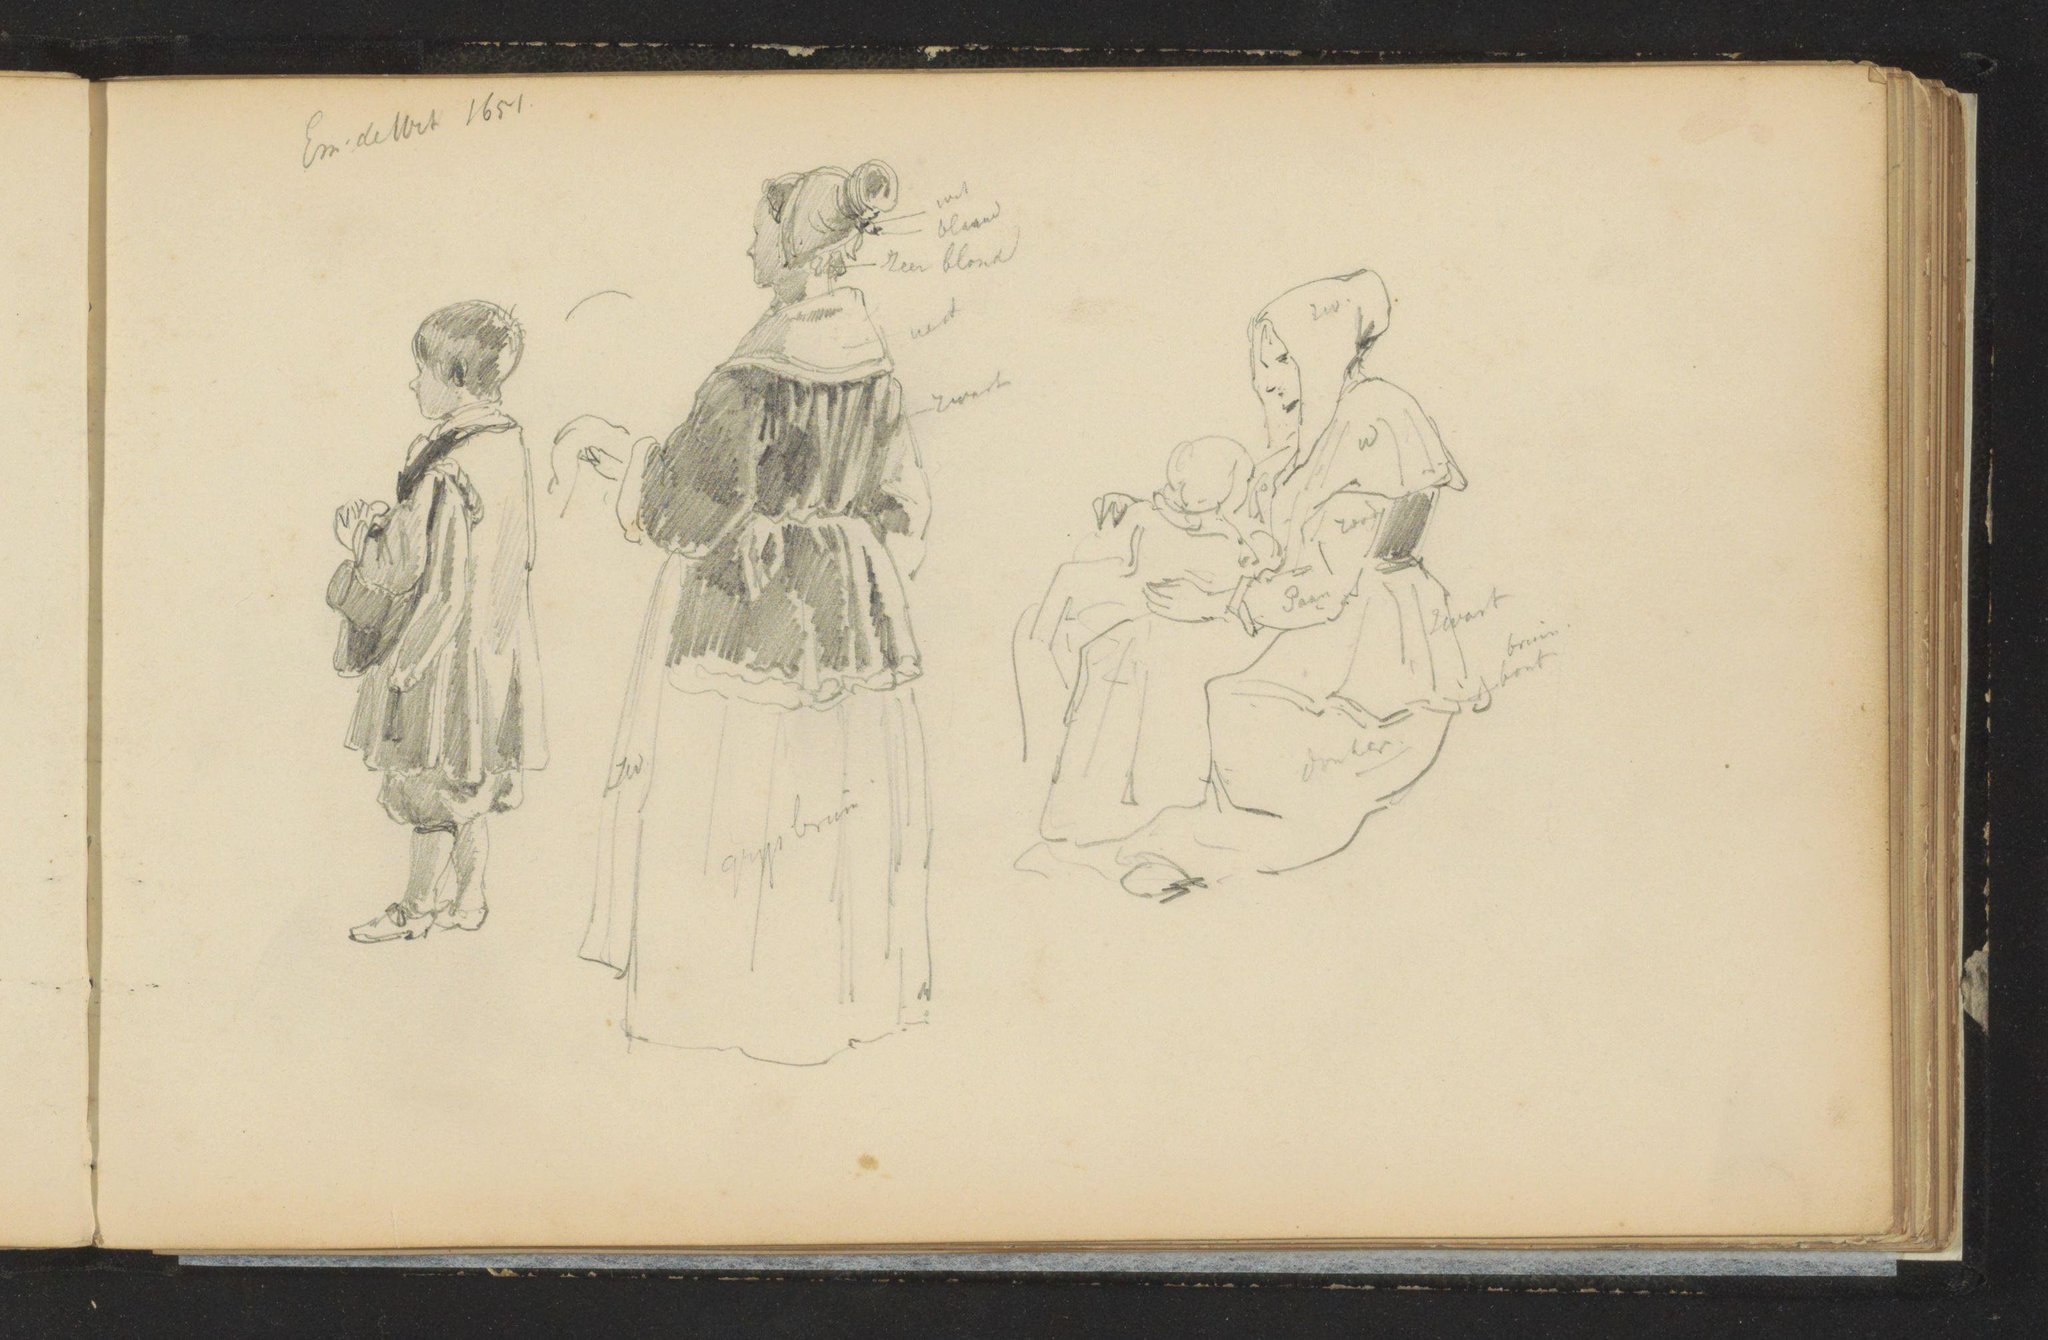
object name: sketchbook leaf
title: Vrouwen en kinderen in zeventiende-eeuwse kleding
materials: paper, pencil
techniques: stumping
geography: amsterdam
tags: boy (child between toddler and youth), dog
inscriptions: annotation: ‘Em de Wit 1651’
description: Links een jongen met gevouwen handen. Rechts een zittende vrouw met een kind. Blad 39 uit een schetsboek met 91 bladen.